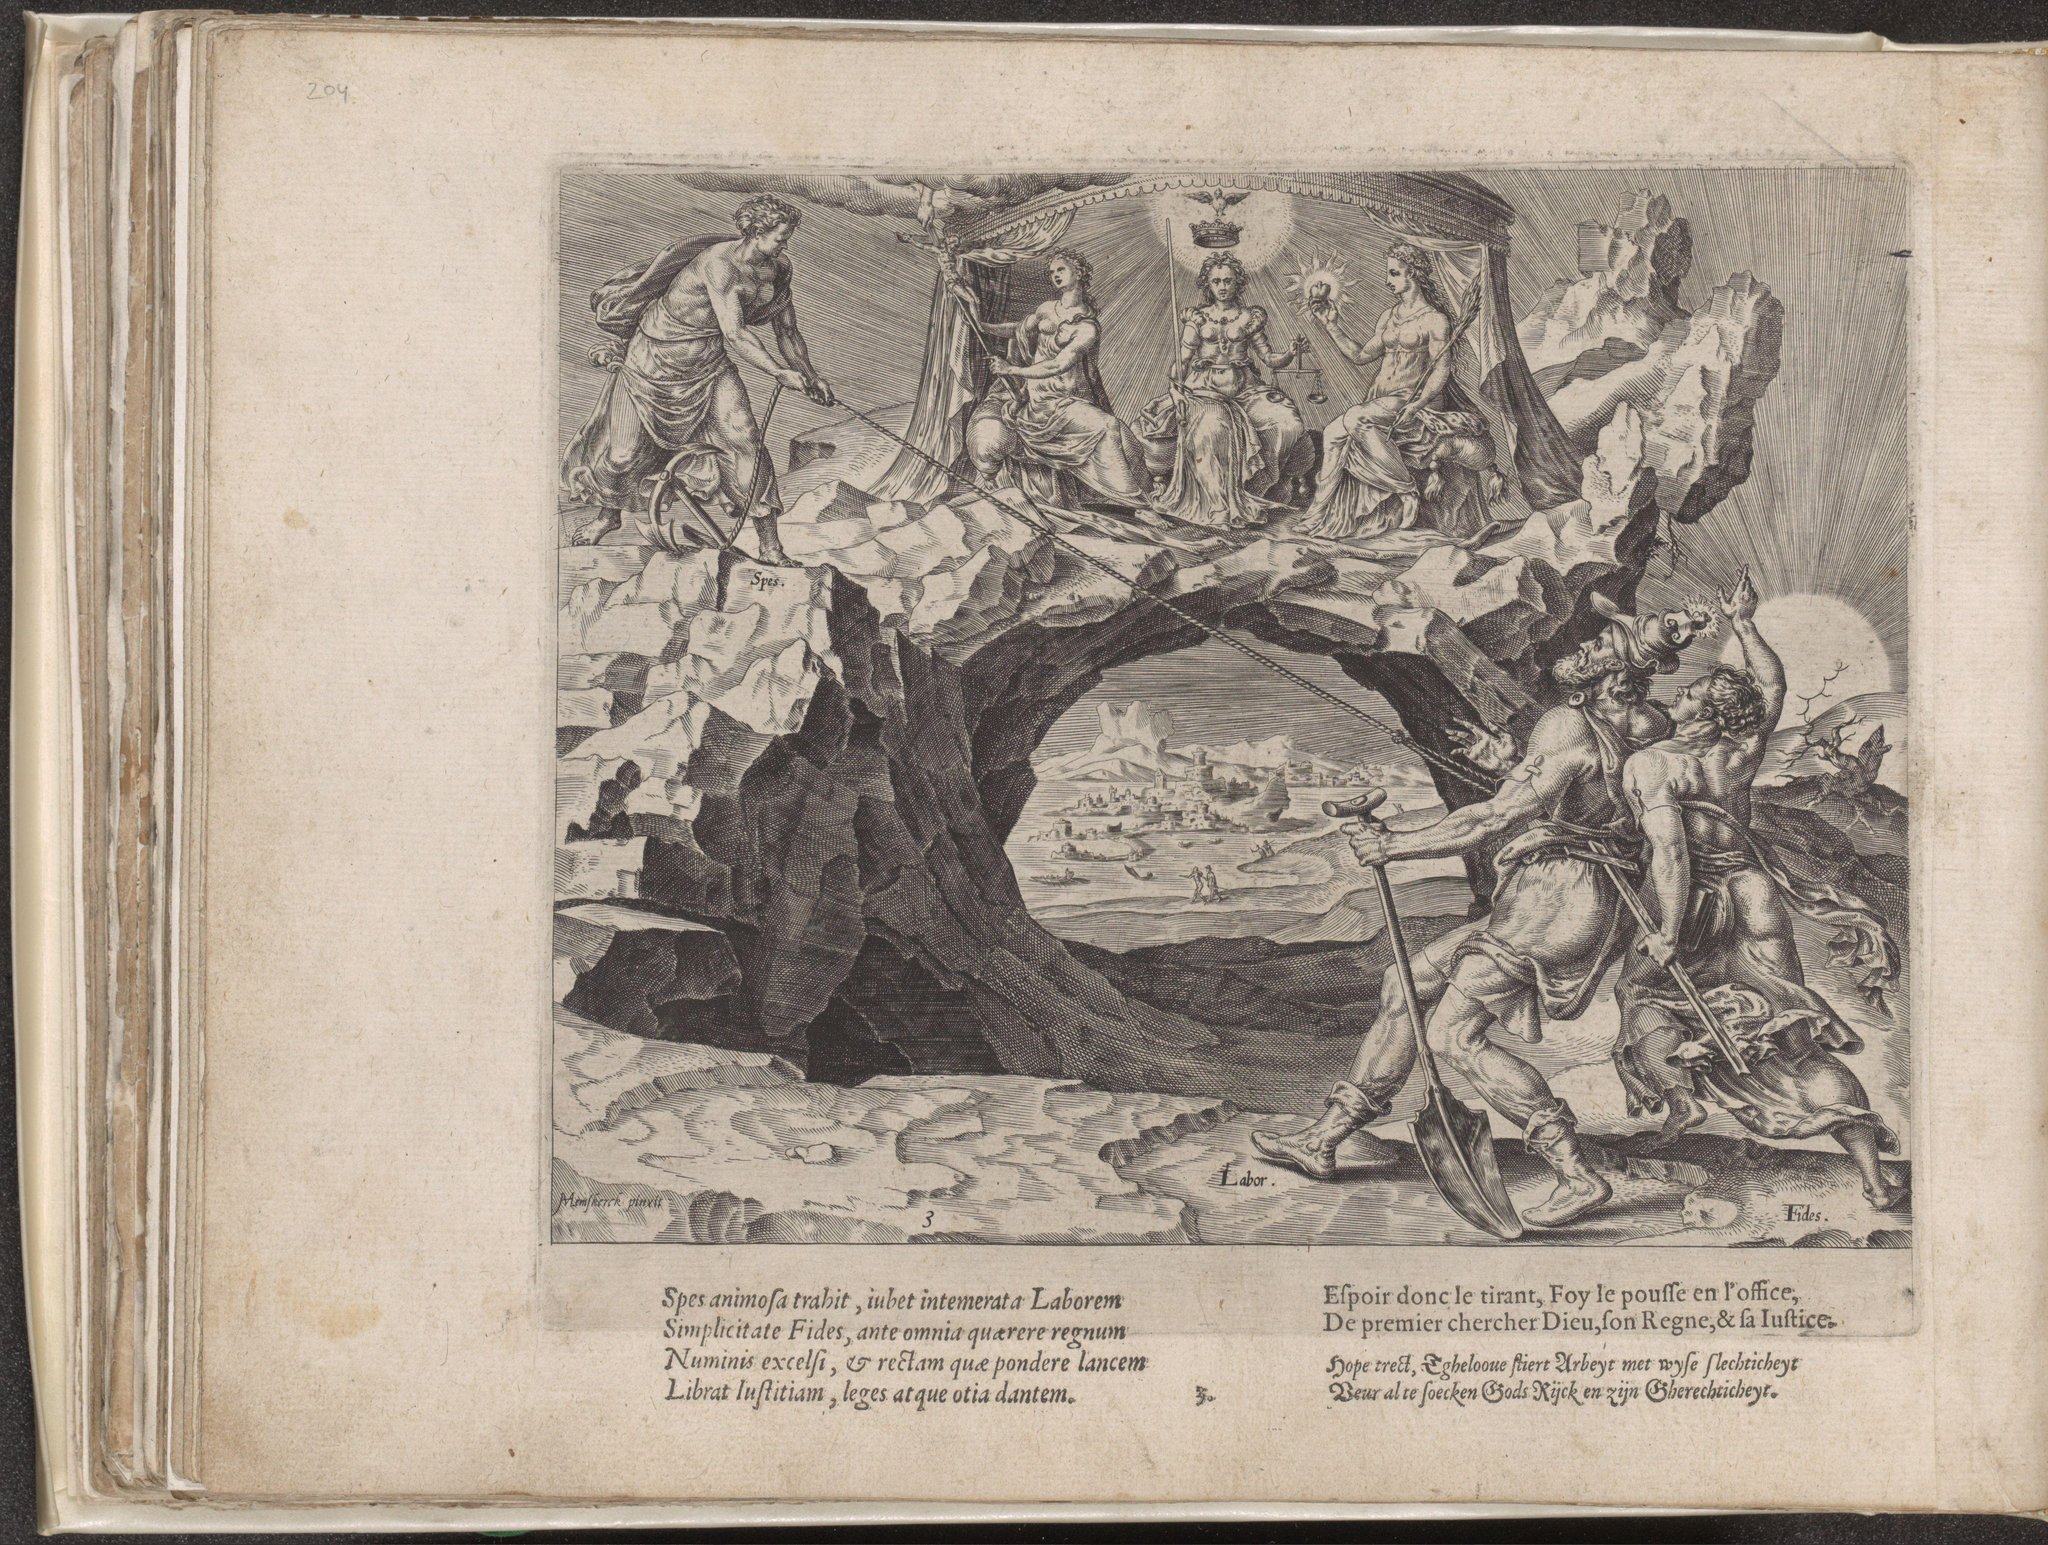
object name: album leaf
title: Geloof en hoop brengen de arbeider tot Gods koninkrijk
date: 1572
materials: paper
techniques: engraving, letterpress printing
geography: antwerp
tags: meekness; 'mansuetudine' (ripa), faith, 'fides'; 'fede', 'fede catholica', 'fede christiana', 'fede christiana catholica' (ripa) ~ one of the three theological virtues, hope, 'spes'; 'speranza divina e certa' (ripa) ~ one of the three theological virtues, divine decree of redemption, allegorical figures present, e.g. justice, mercy, peace and truth (the virtues reconciled), piety, 'pietas', 'timor dei' ~ the three theological virtues, labour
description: De personificatie van Arbeid (Labor) wordt door Geloof (Fides) richting een brug geduwd. Door middel van een touw dat rond zijn middel is gebonden wordt Arbeid door Hoop (Spes) verder naar de brug toe getrokken. Op de brug zitten de personificaties van Gods koninkrijk en zijn Gerechtigheid onder de baldakijn van de Heilige Geest. Onder de voorstelling een vierregelig vers in het Latijn en twee verzen in het Frans en Nederlands in boekdruk. Deze prent maakt deel uit van een album.